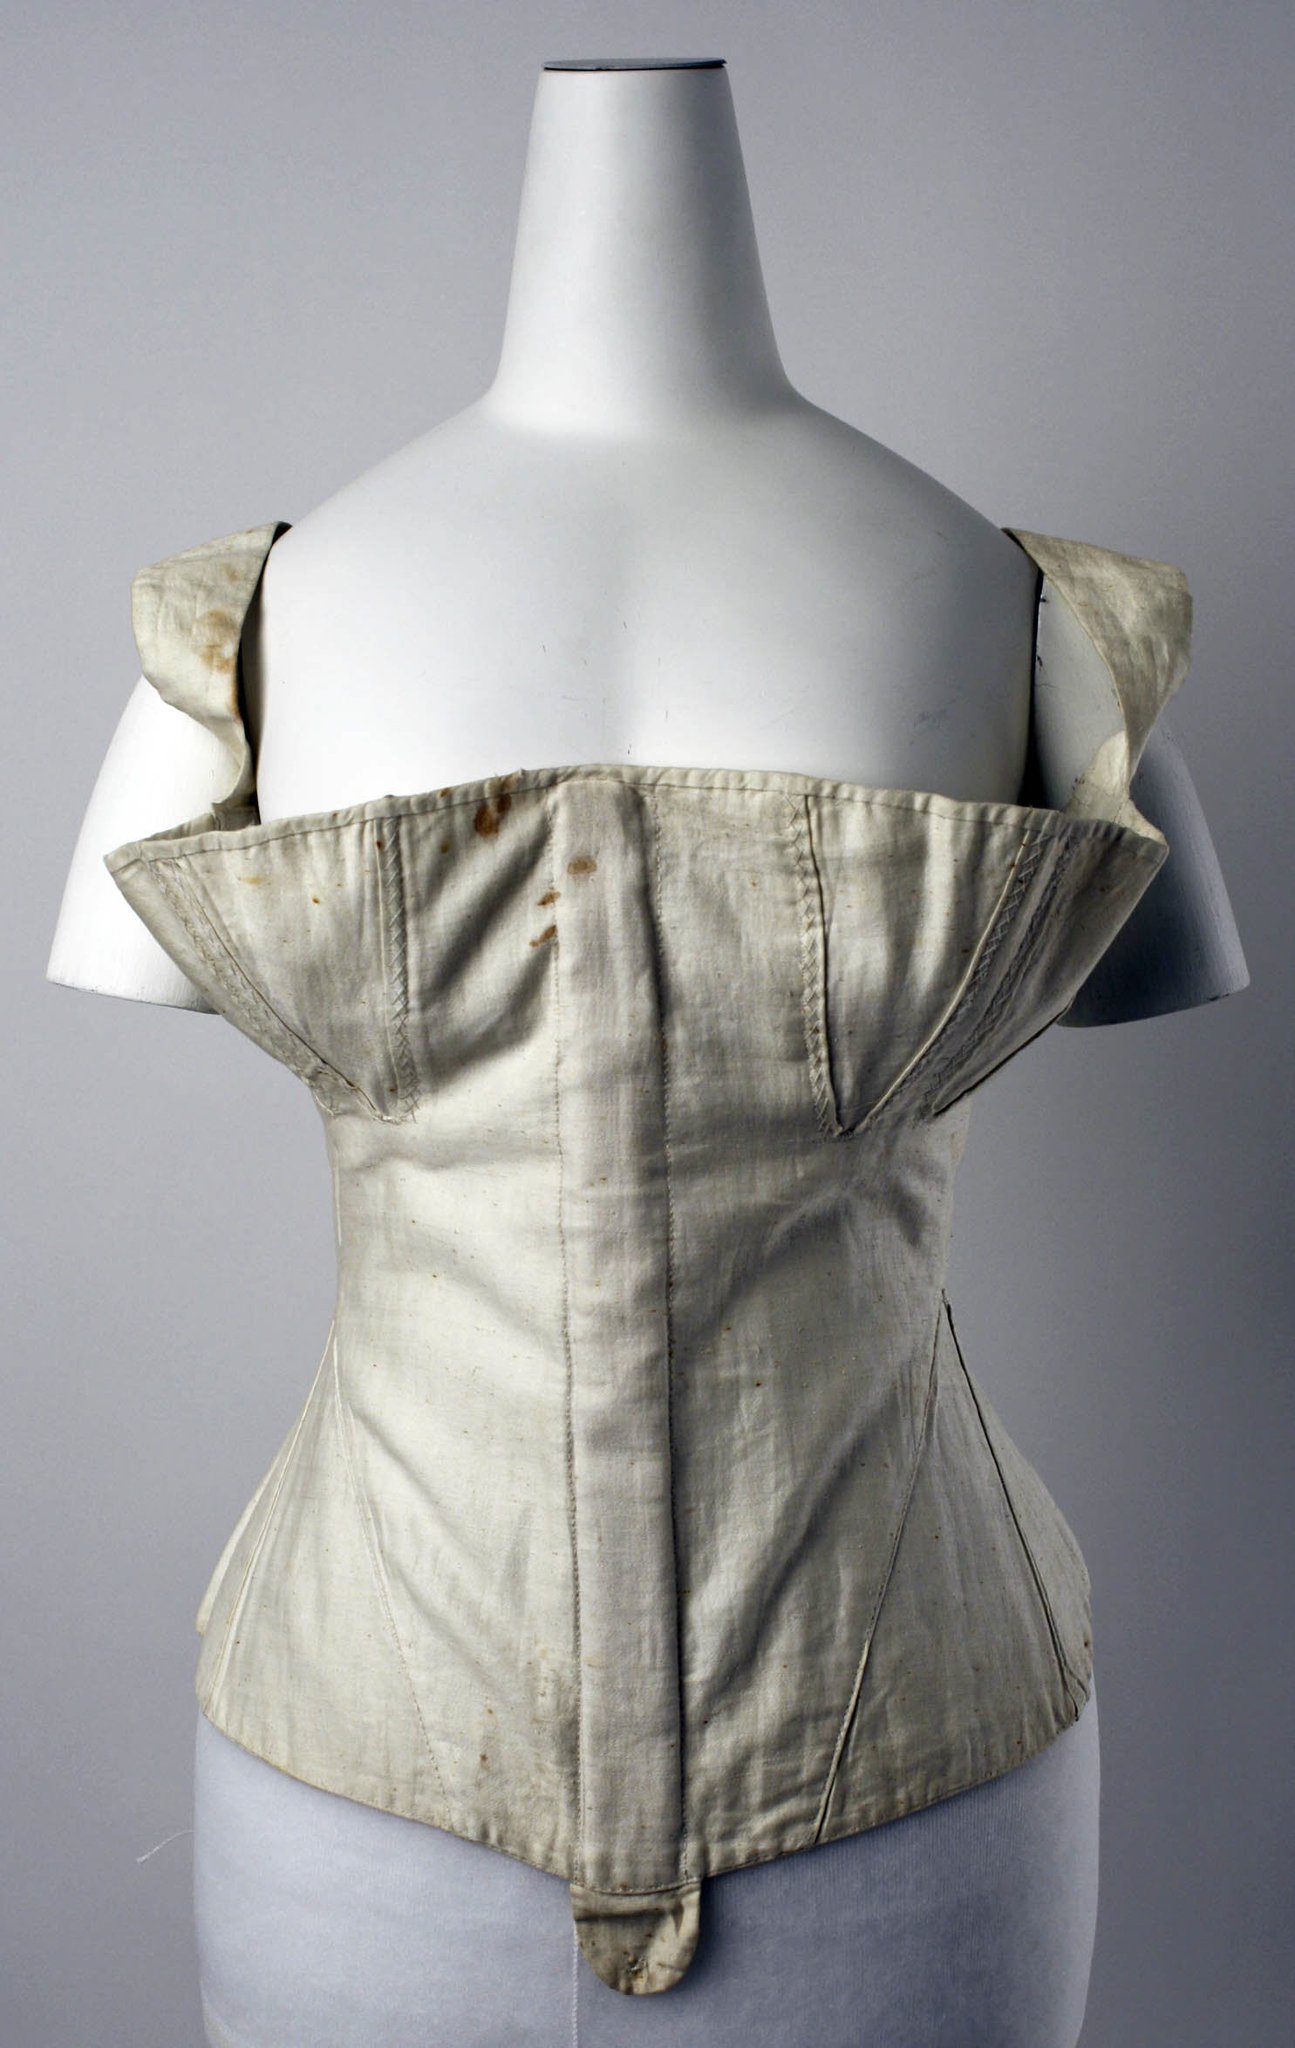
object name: corset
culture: american or european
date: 1830-1839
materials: cotton